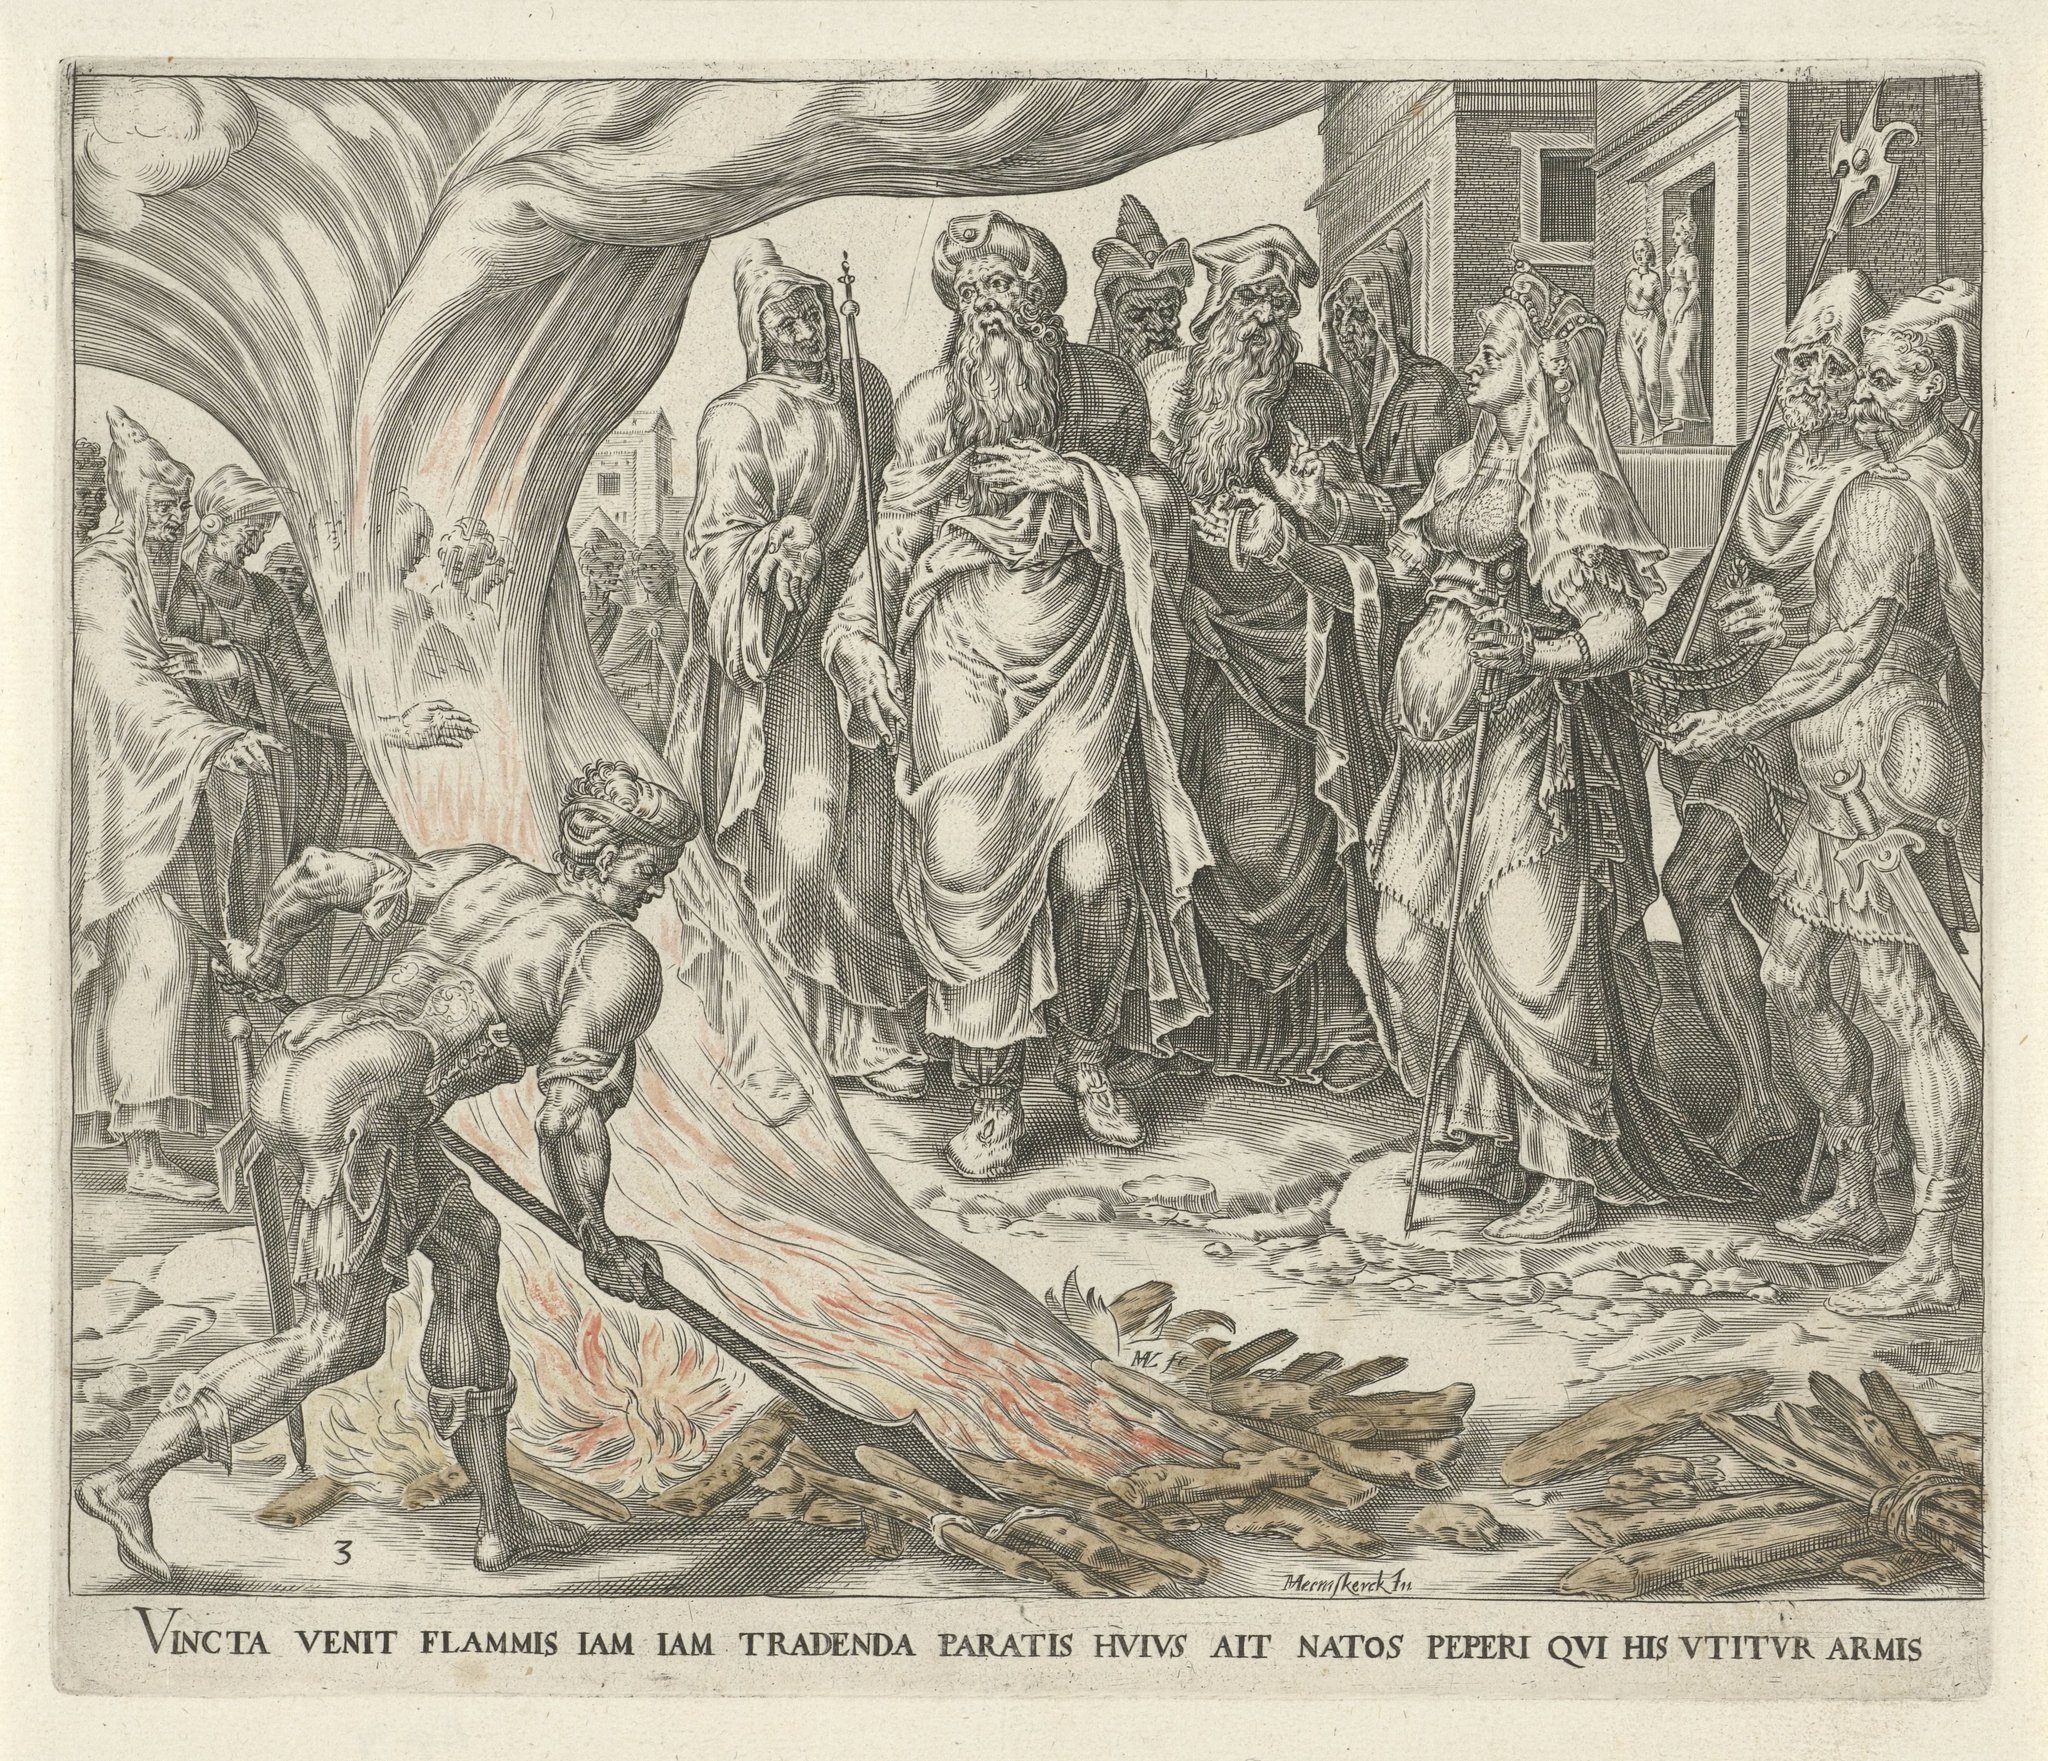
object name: print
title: Geschiedenis van Juda en Tamar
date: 1564-1568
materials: paper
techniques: engraving, hand coloring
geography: amsterdam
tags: the burning of tamar being ordered, she shows the signet(-ring), bracelets and staff to judah, who recognizes them as his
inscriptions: collector's mark: Lugt 2228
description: Juda laat het vuur opstoken om zijn schoondochter Tamar te verbranden. Hij wil haar straffen omdat ze zich als een hoer heeft gedragen en daardoor zwanger is geworden. Tamar toont hem echter zijn staf en zegelring, waarmee ze bewijst dat hij haar zwanger heeft gemaakt. Daarna erkent Juda dat hij schuldig is en Tamar niet. Onderaan in de marge een vers in het Latijn.